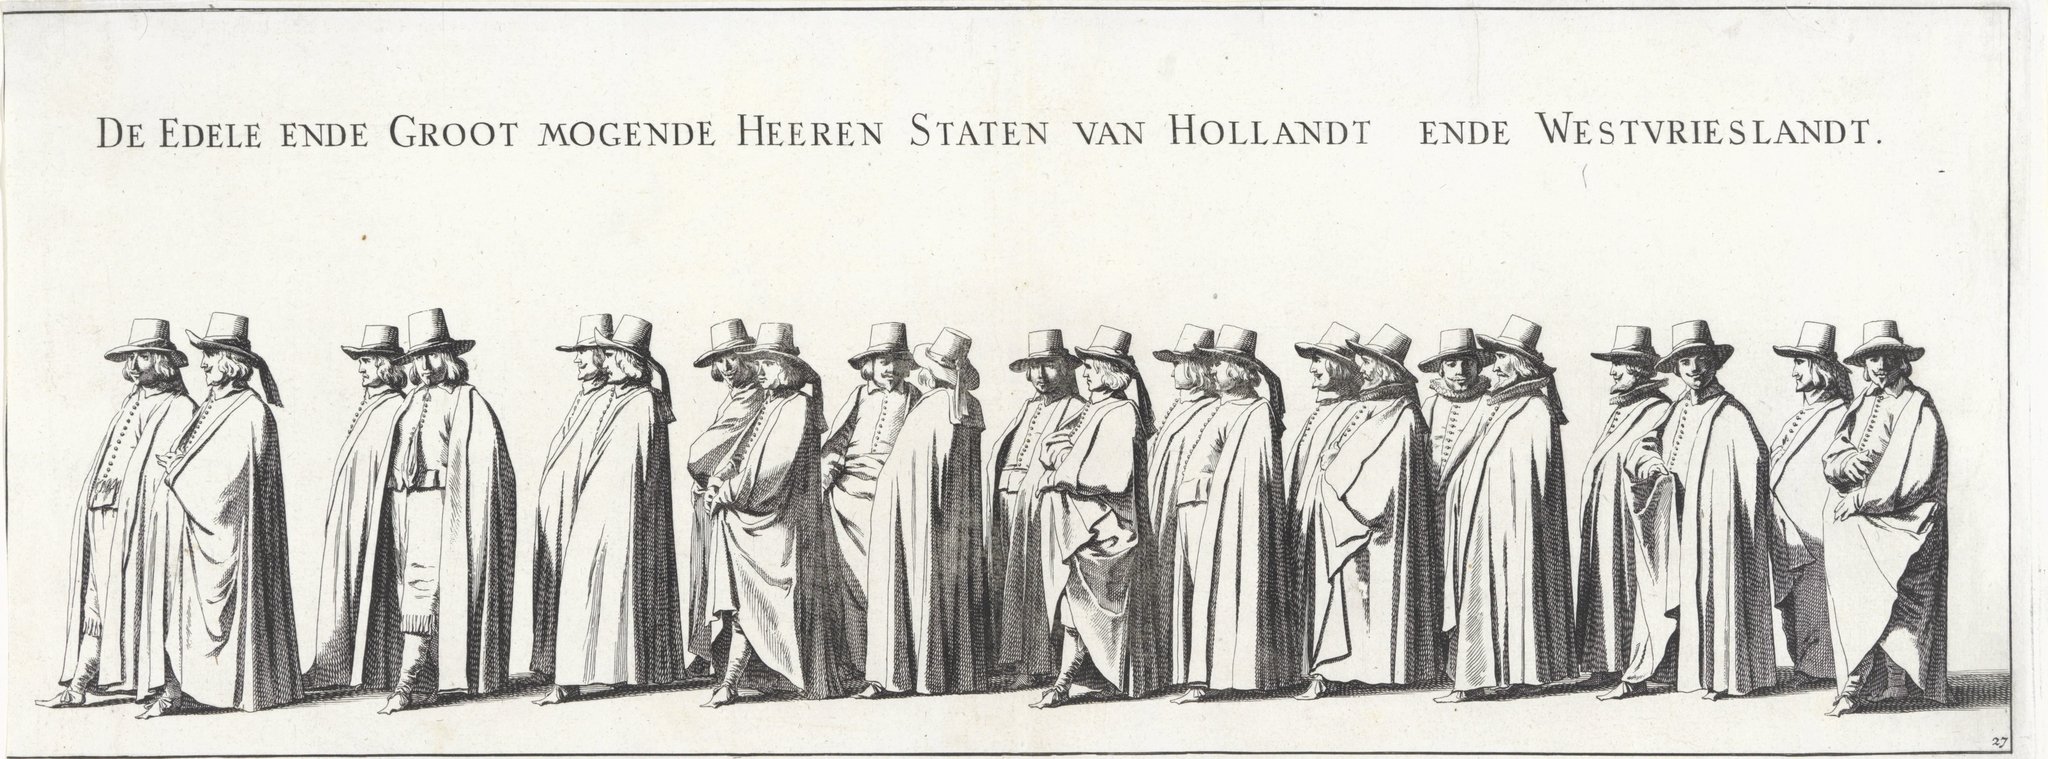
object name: print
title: De begrafenisstoet van stadhouder Frederik Hendrik te 's-Gravenhage in 1647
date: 1651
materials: paper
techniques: engraving, etching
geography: the hague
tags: cortege, funeral procession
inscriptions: collector's mark: Lugt 2228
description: De begrafenisstoet van stadhouder Frederik Hendrik te 's-Gravenhage op 10 mei 1647. Plaat nr. 27 met een deel van de stoet met leden van de Staten van Holland en West-Friesland, boven de personen staat hun functie. Onderdeel van een serie van 30 platen en 20 tekstbladen, bedoeld om aan elkaar geplakt te worden.